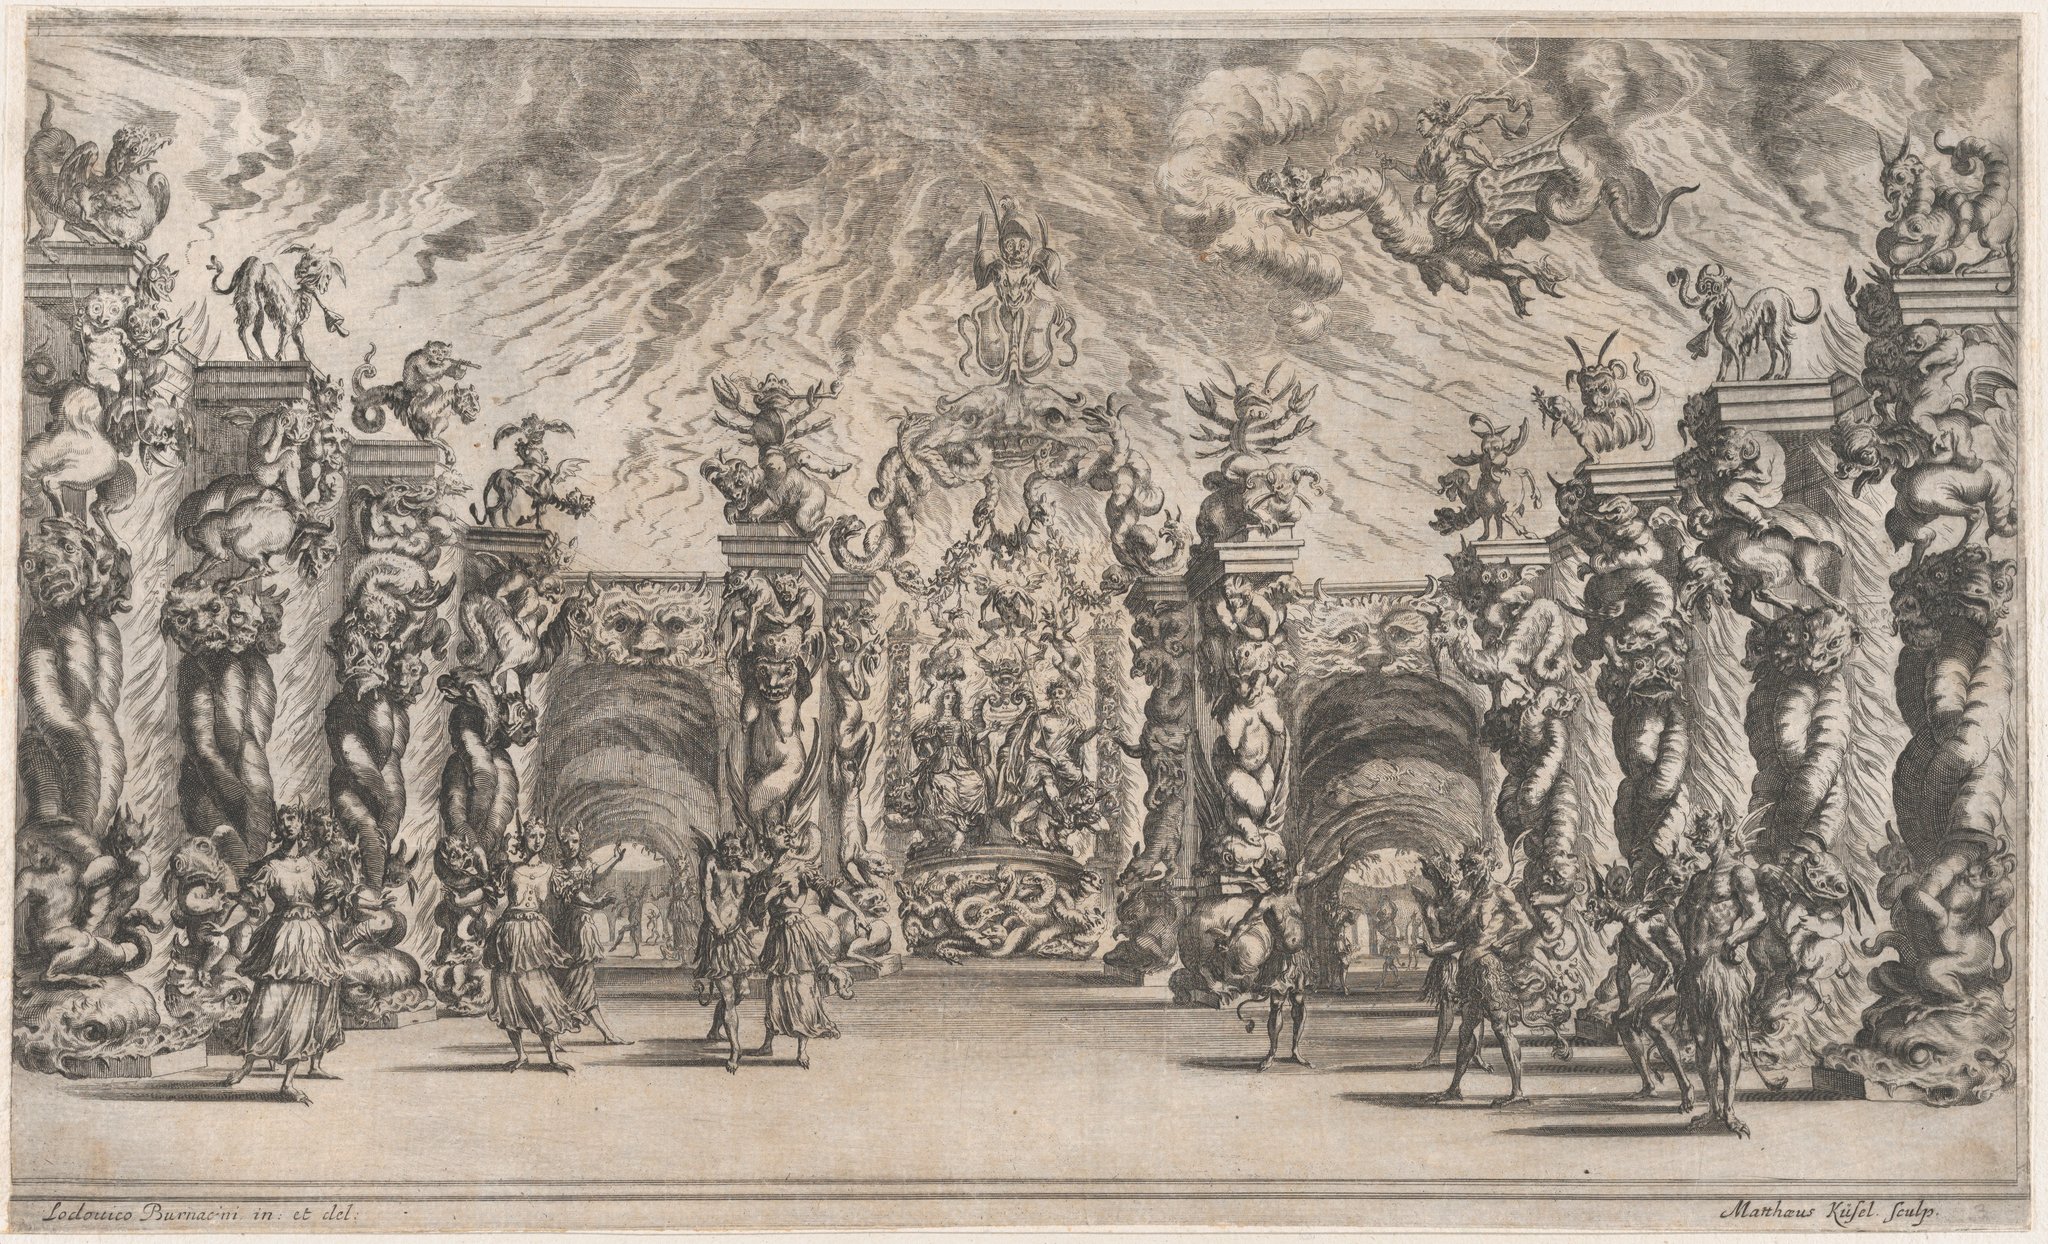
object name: print, fete, ornament architecture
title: Kingdom of Pluto; a view of the underworld with Pluto and Proserpina enthroned at center, surrounded by demons; set design from 'Il Pomo D'Oro'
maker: mathäus küsel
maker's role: artist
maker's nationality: german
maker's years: 1621-1682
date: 1668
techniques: etching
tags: opera,demons,pluto